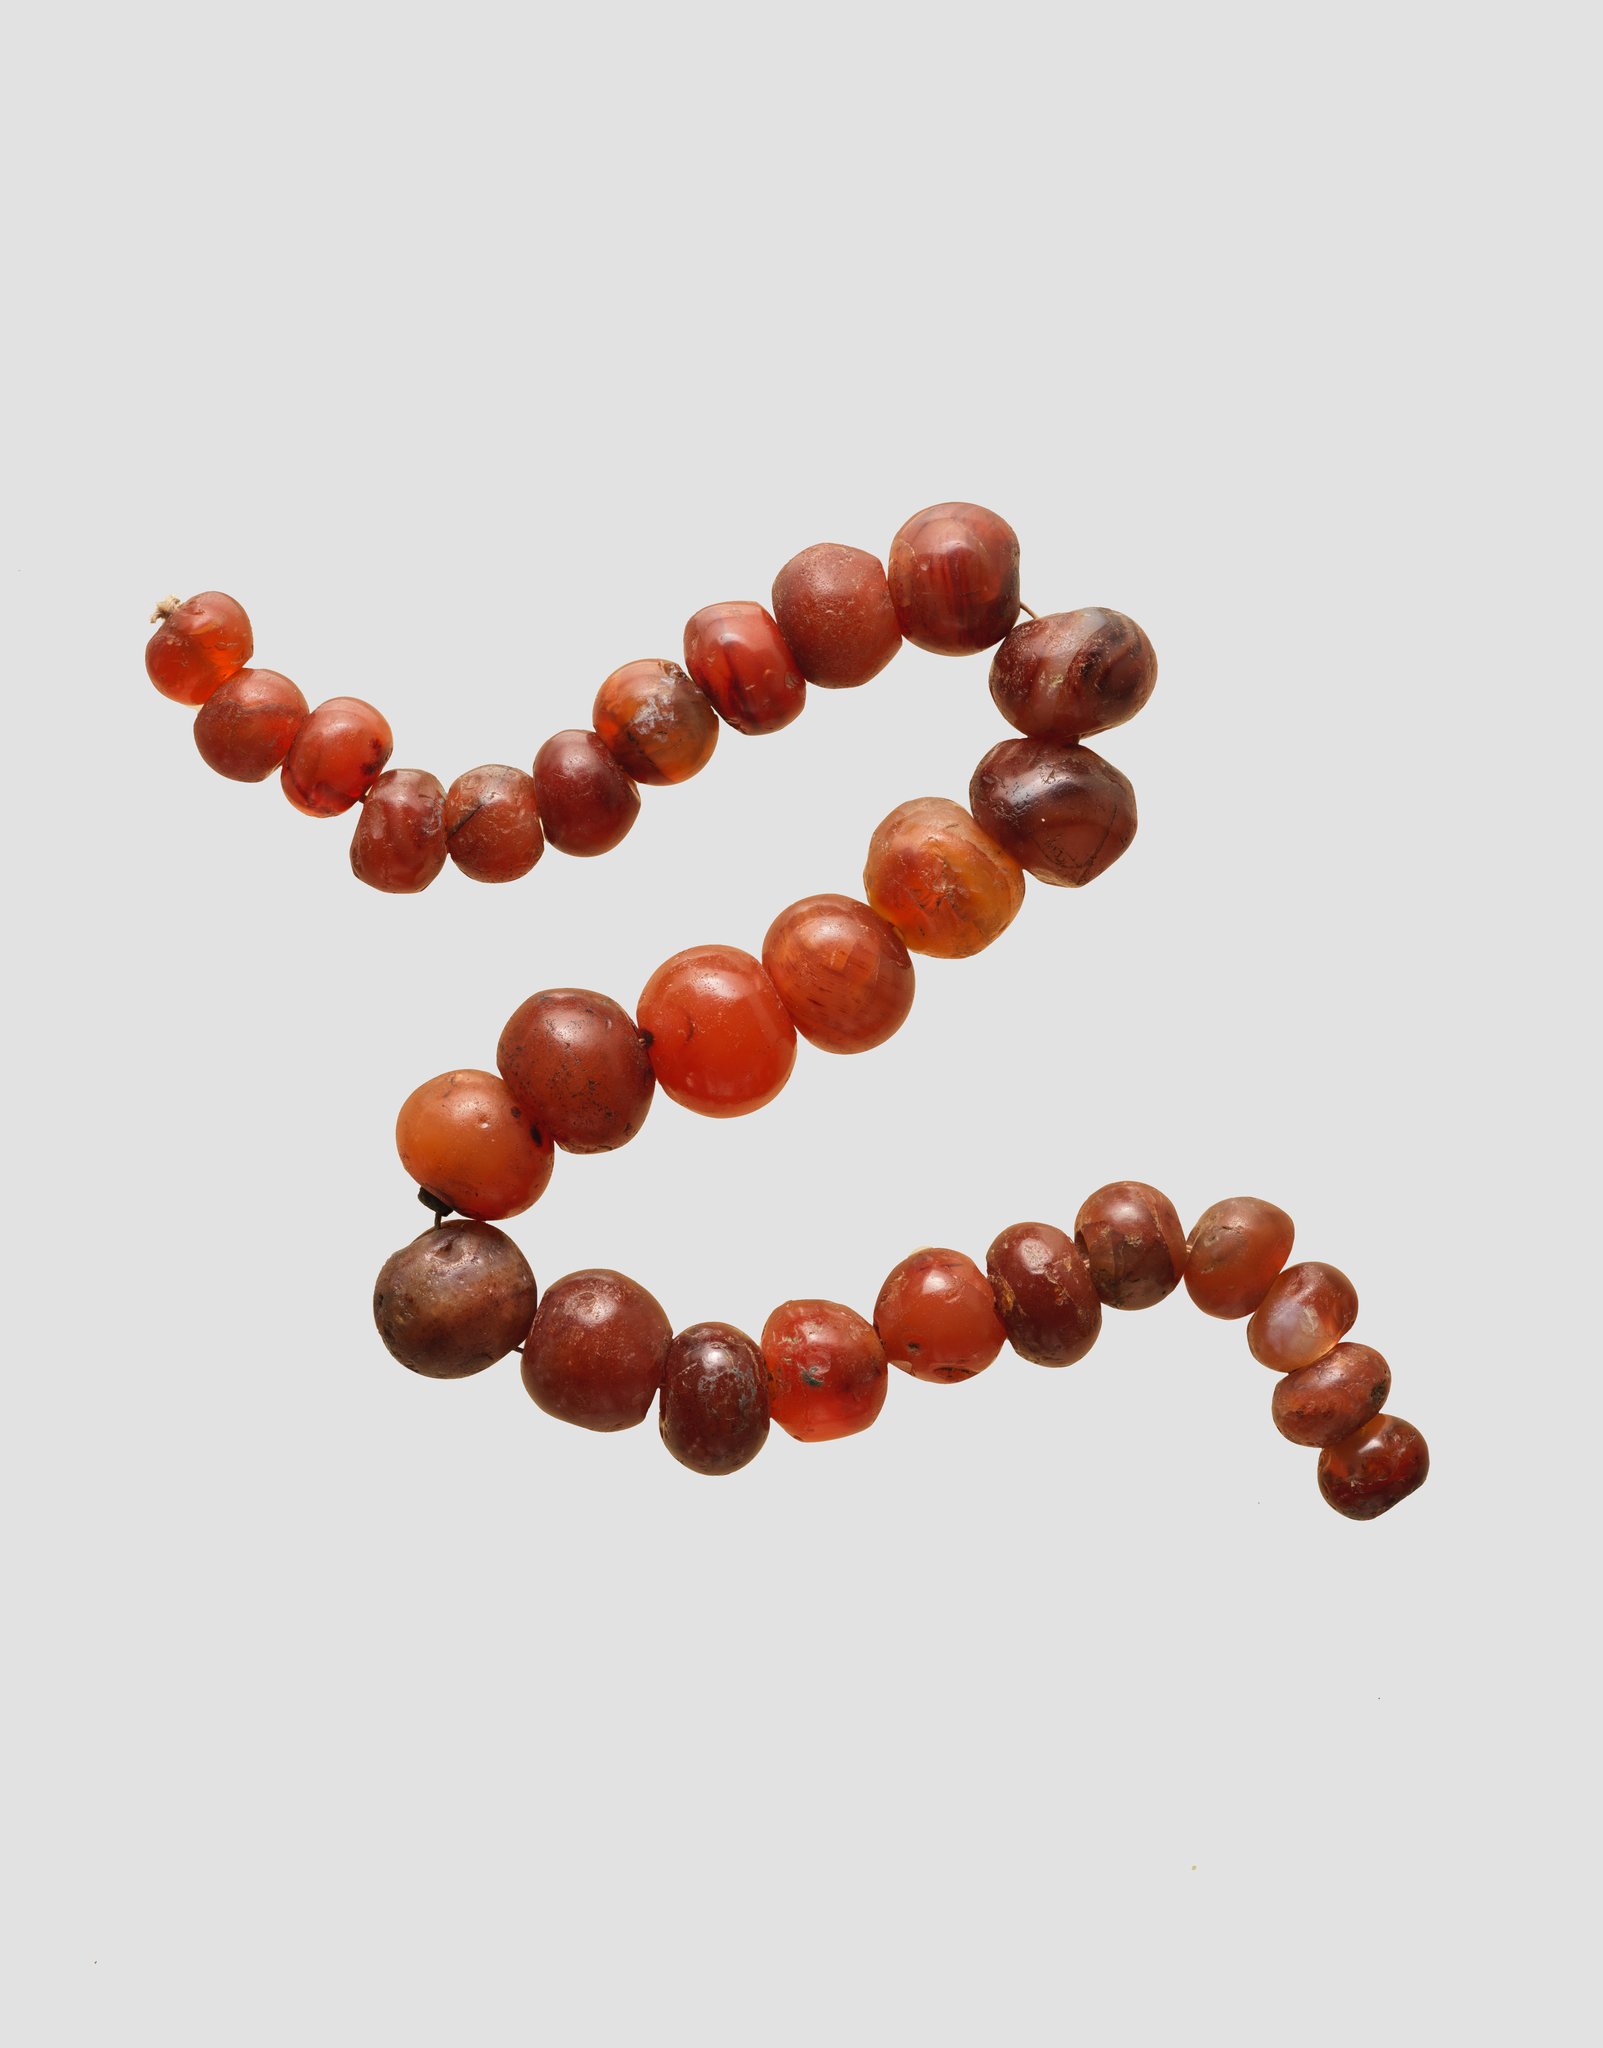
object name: bead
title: Beads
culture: iranian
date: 900-801 BCE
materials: gemstone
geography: iran